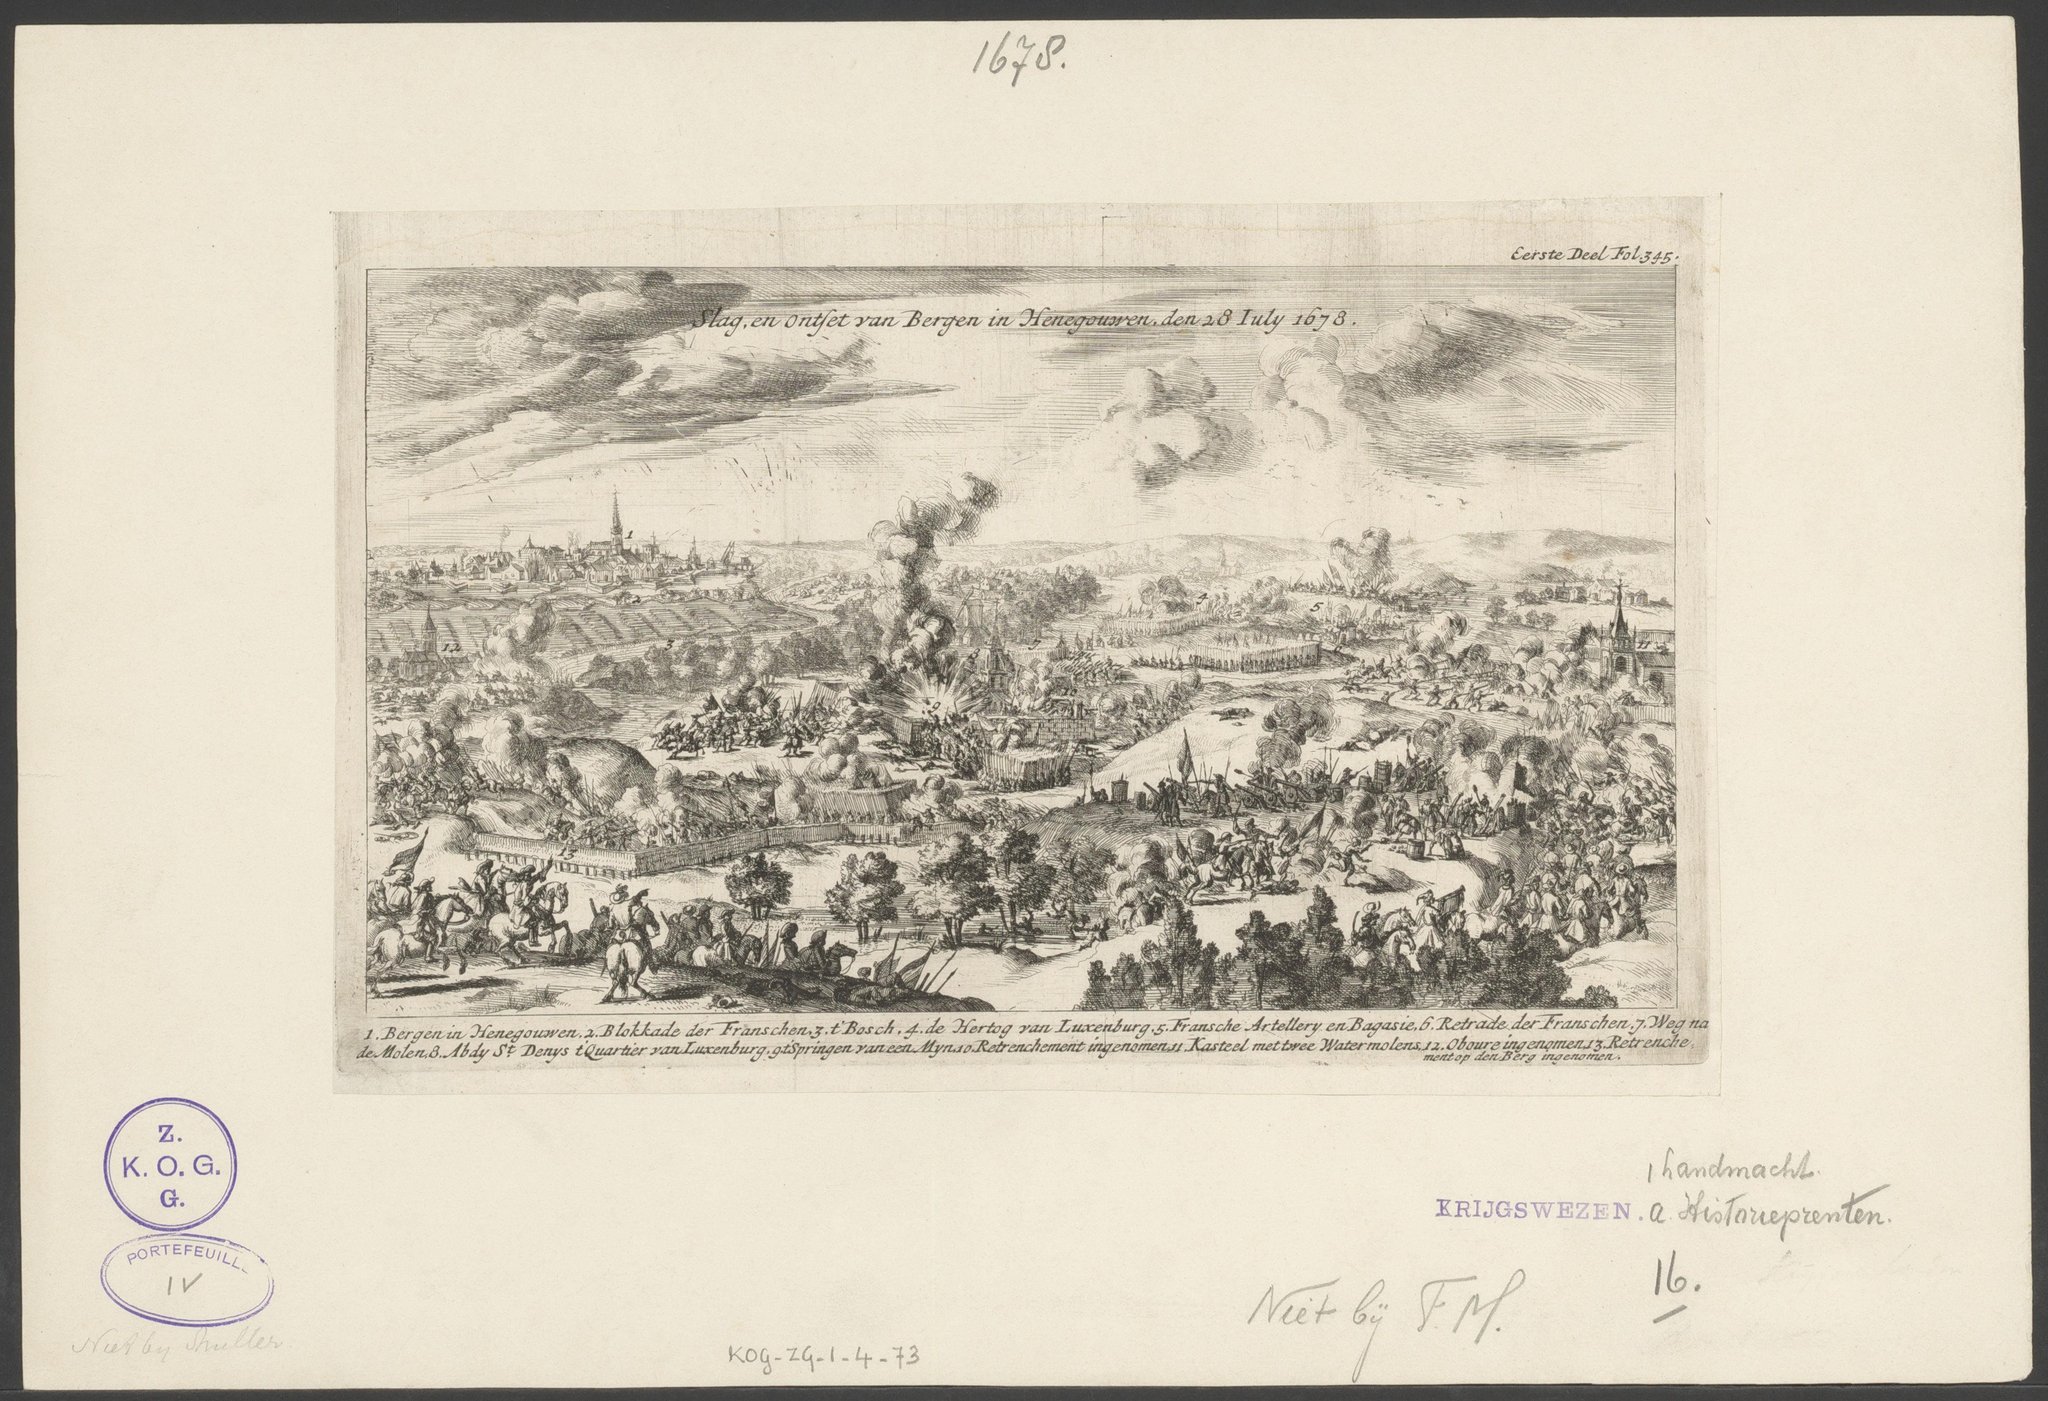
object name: history print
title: Slag en Ontset van Bergen in Henegouwen, den 28 July 1678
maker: jan luyken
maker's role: draughtsman, print maker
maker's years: 1649-1712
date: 1692-1694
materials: paper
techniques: etching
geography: northern netherlands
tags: the hague, william iii (prince of orange and king of england, scotland, and ireland), battle (+ land forces)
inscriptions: collector's mark, collector's mark: Lugt 1641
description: Gebruikt als illustratie in: Lambert van den Bosch, Het leven en bedryf van Willem de Darde, Jan Claesz ten Hoorn, Amsterdam 1694, 4 delen, dl. 1, p. 345.